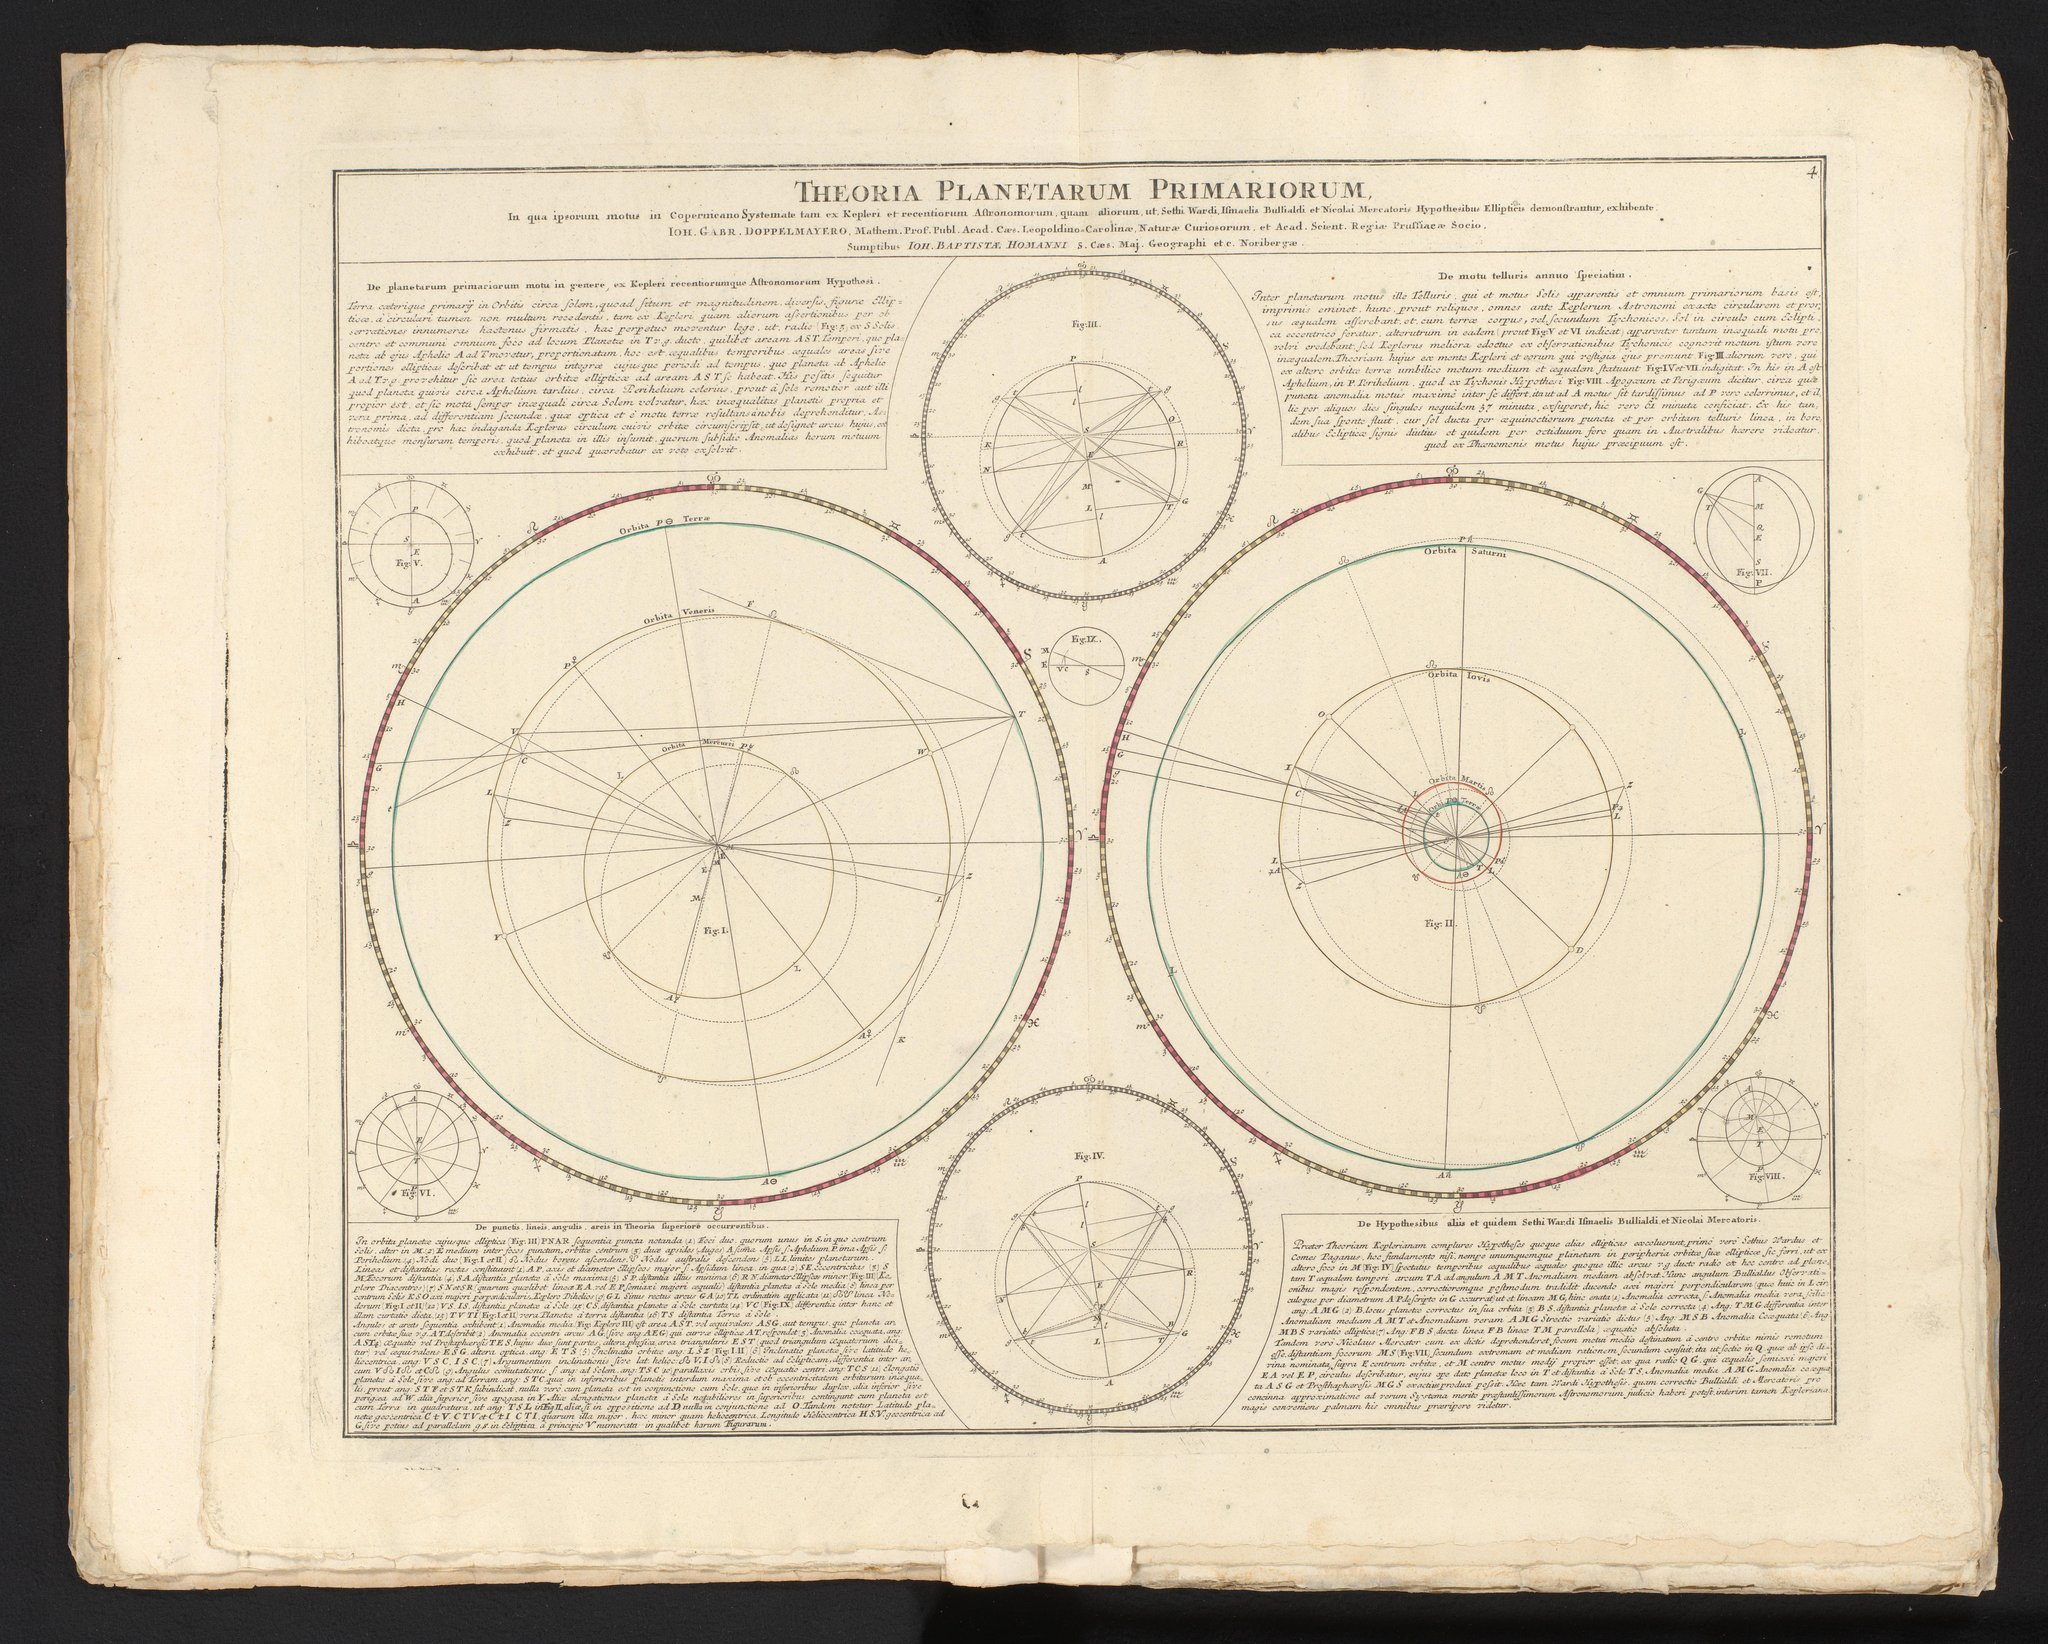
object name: print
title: Theoria planetarum primariorum, in qua ipsorum motus in Copernicano (...)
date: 1742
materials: paper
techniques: engraving, etching, hand coloring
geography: nuremberg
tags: star-chart, star map, stars and constellations, planets; planetary system, solar system